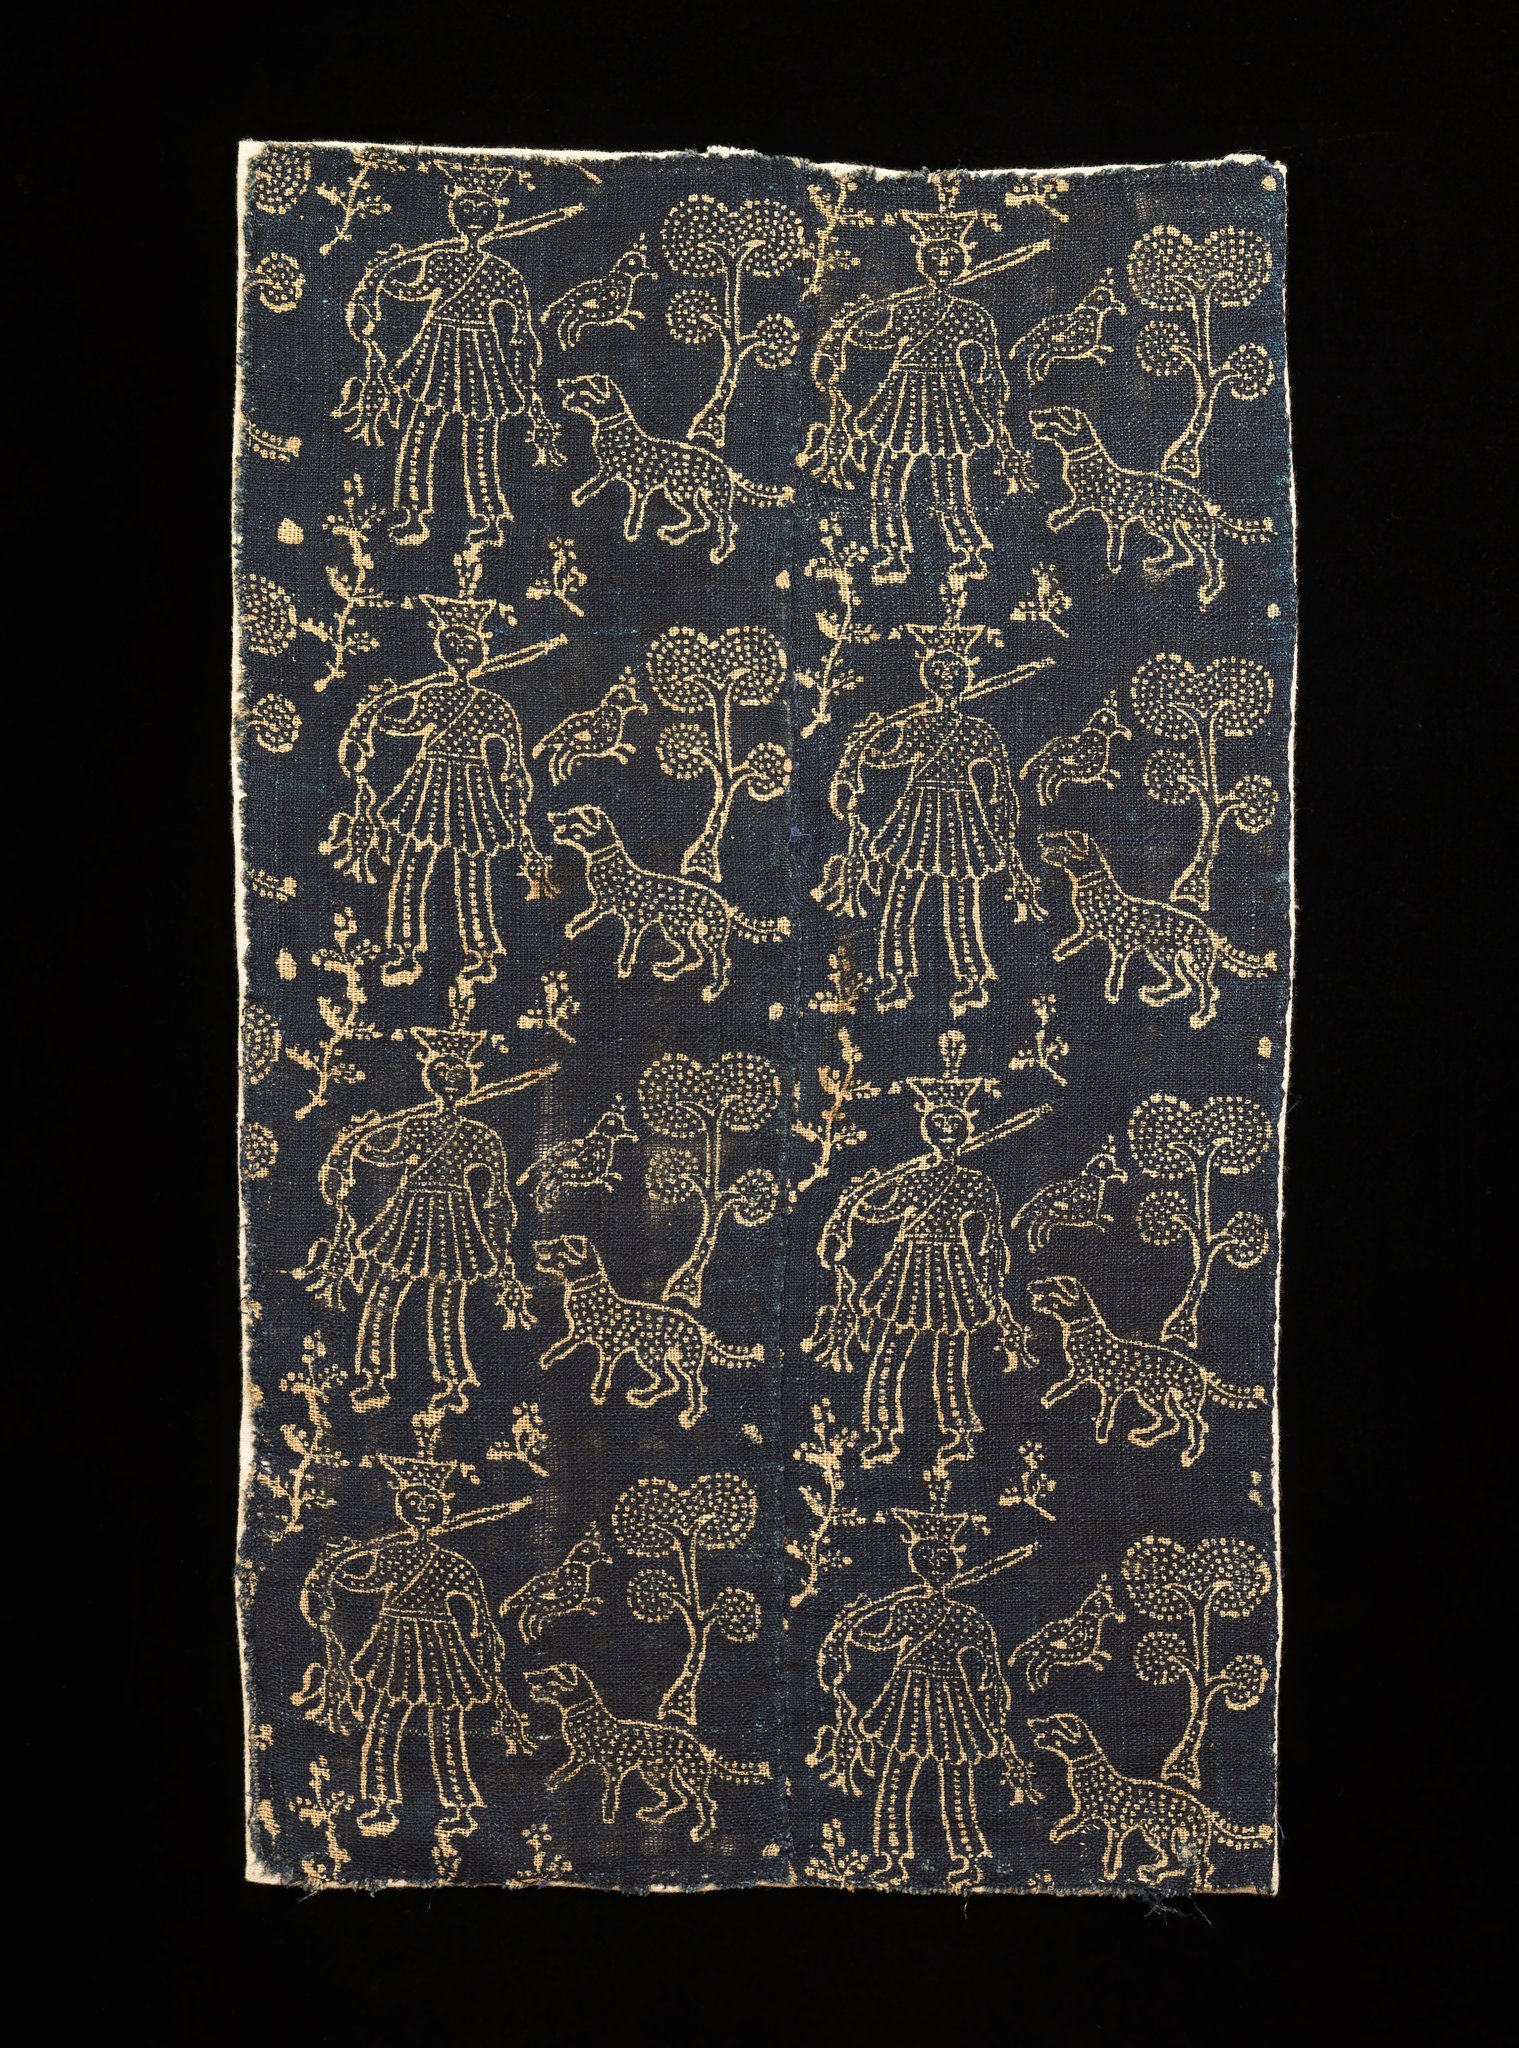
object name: textile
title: Textile fragment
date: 1600-1799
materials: linen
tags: human figures,birds,dogs,trees